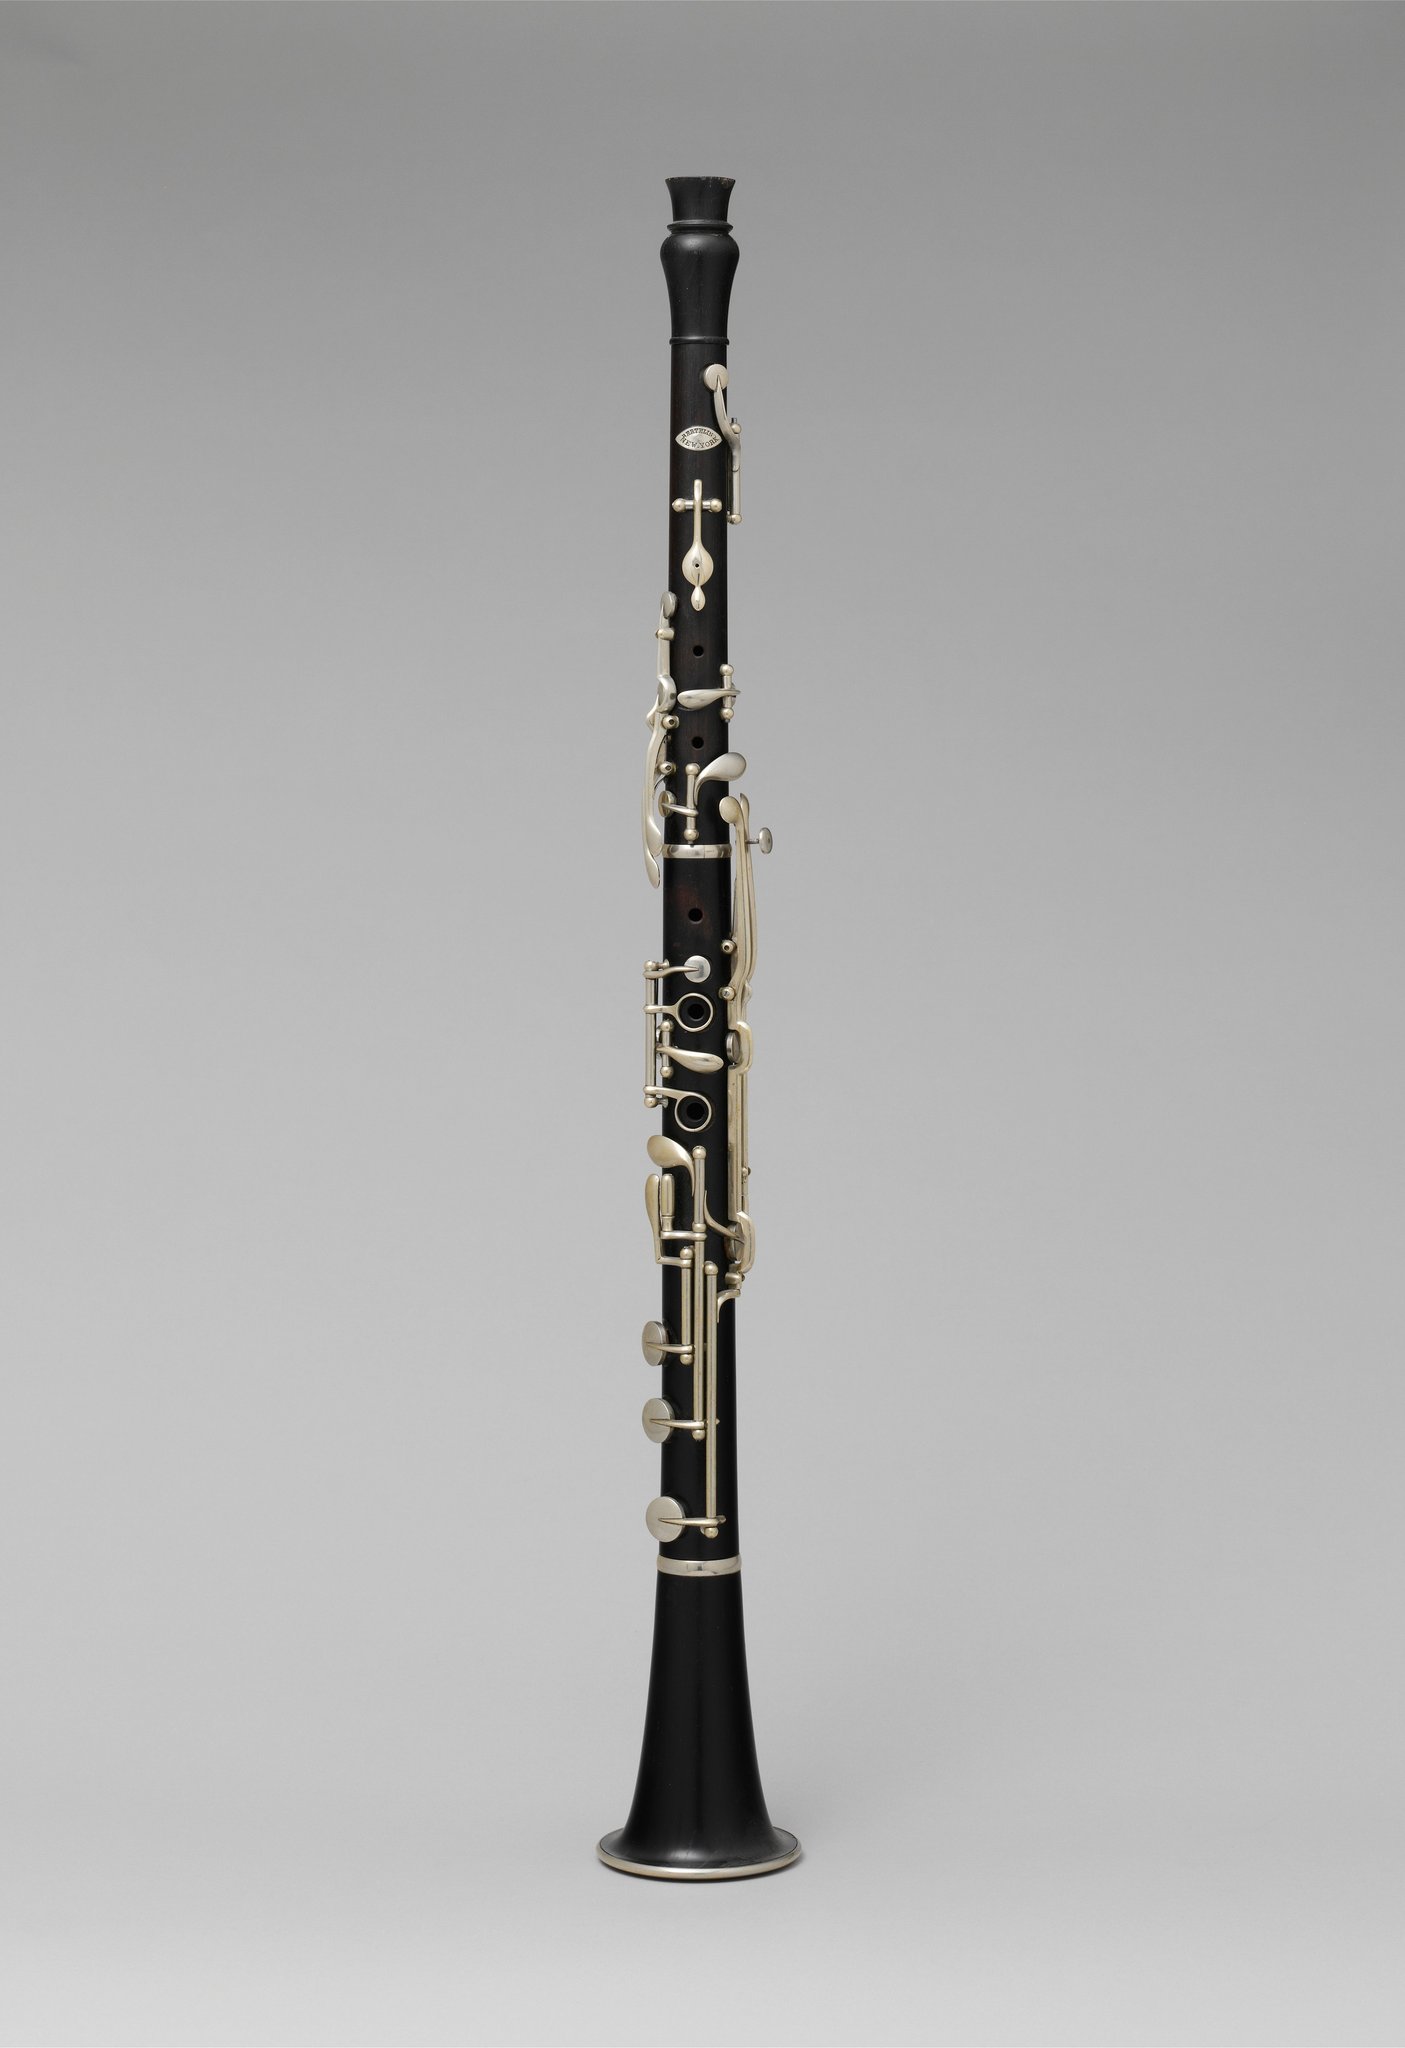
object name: oboe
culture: american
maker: theodore berteling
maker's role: maker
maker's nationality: american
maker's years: 1821-1890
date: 1860-1890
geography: united states